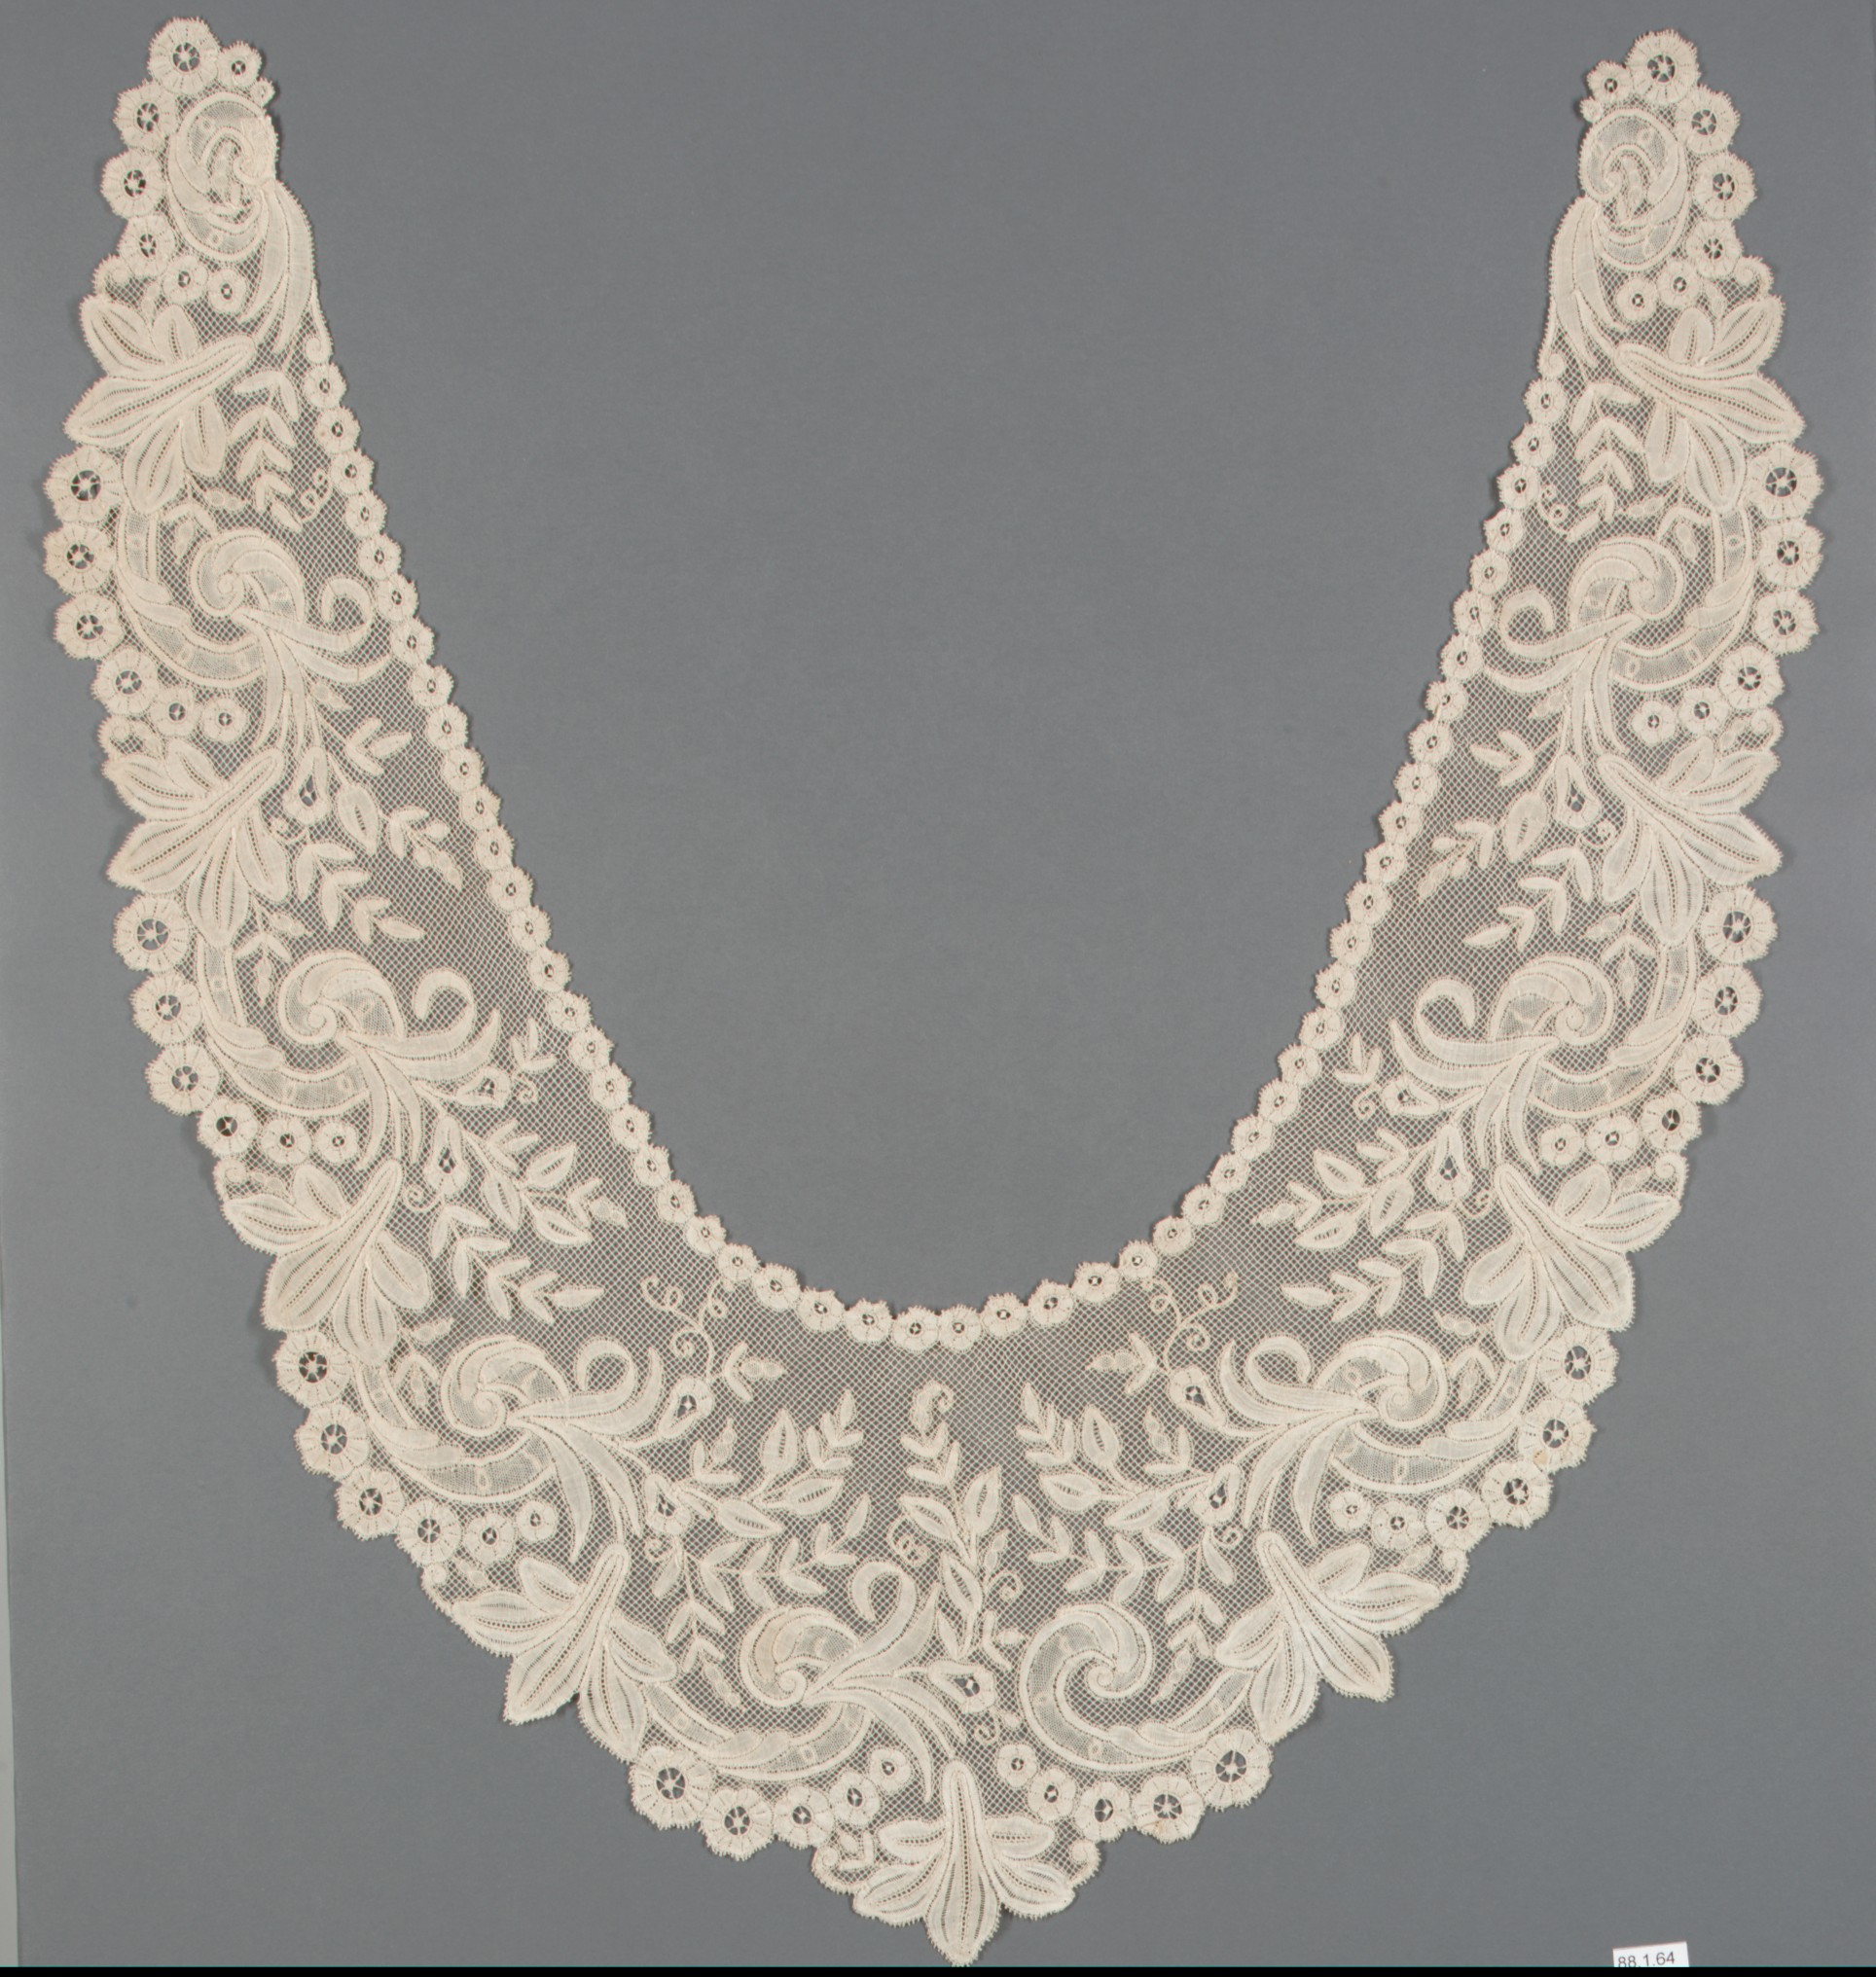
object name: collar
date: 1801-1900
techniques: lace